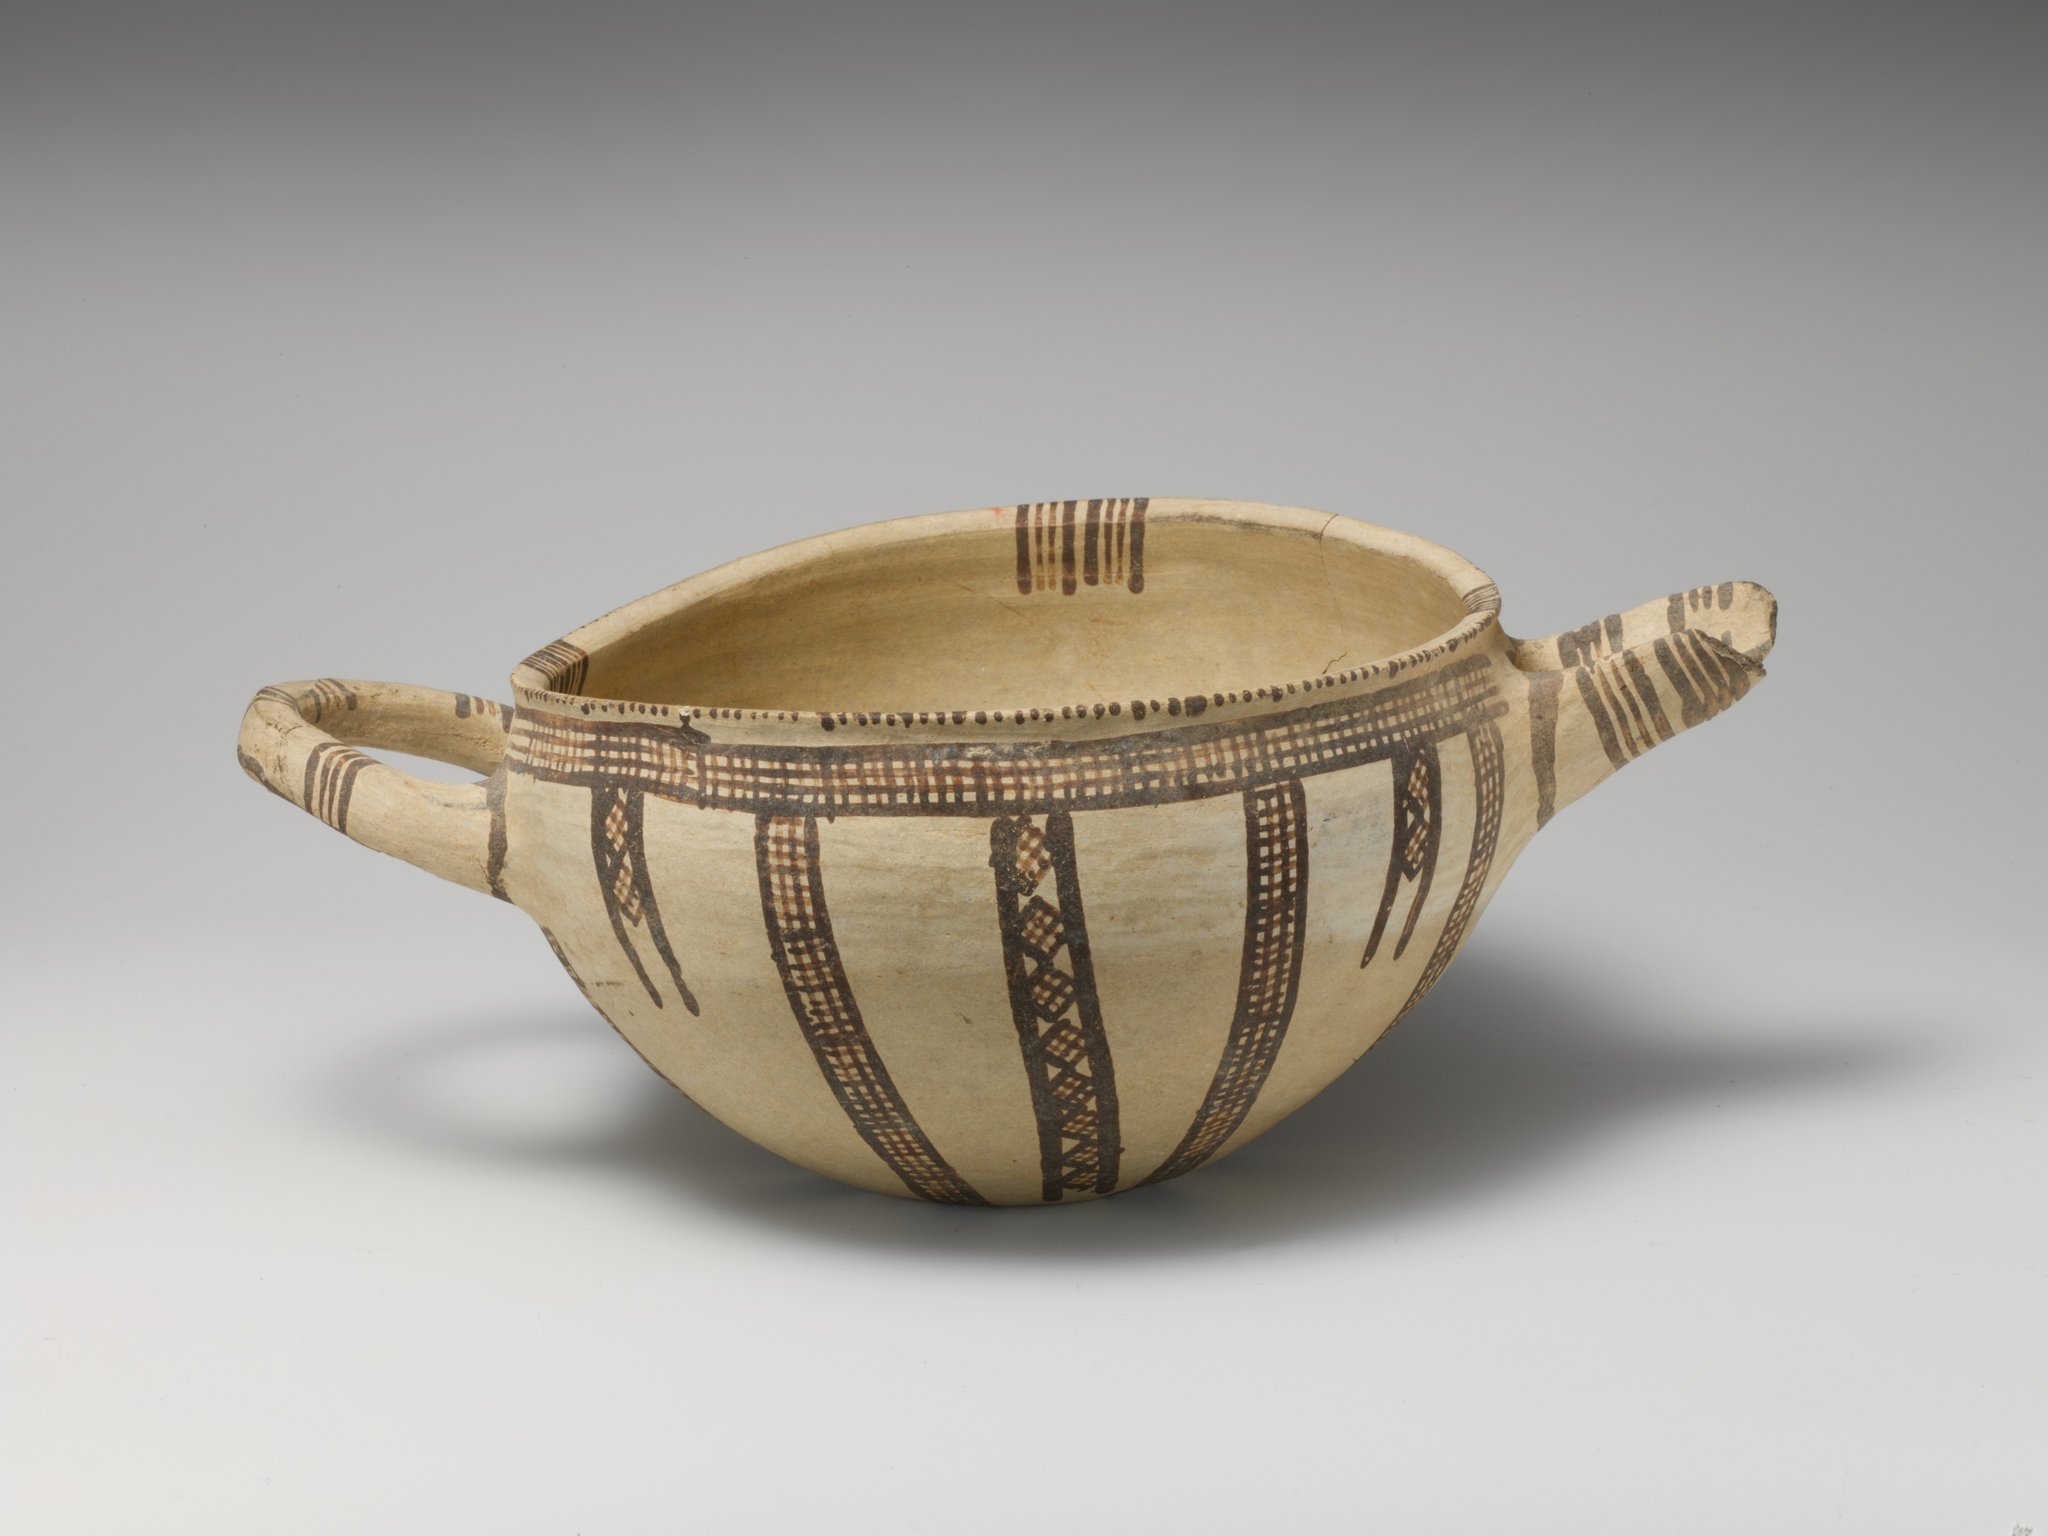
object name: bowl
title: Terracotta two-handled bowl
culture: cypriot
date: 1600-1150 BCE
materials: terracotta